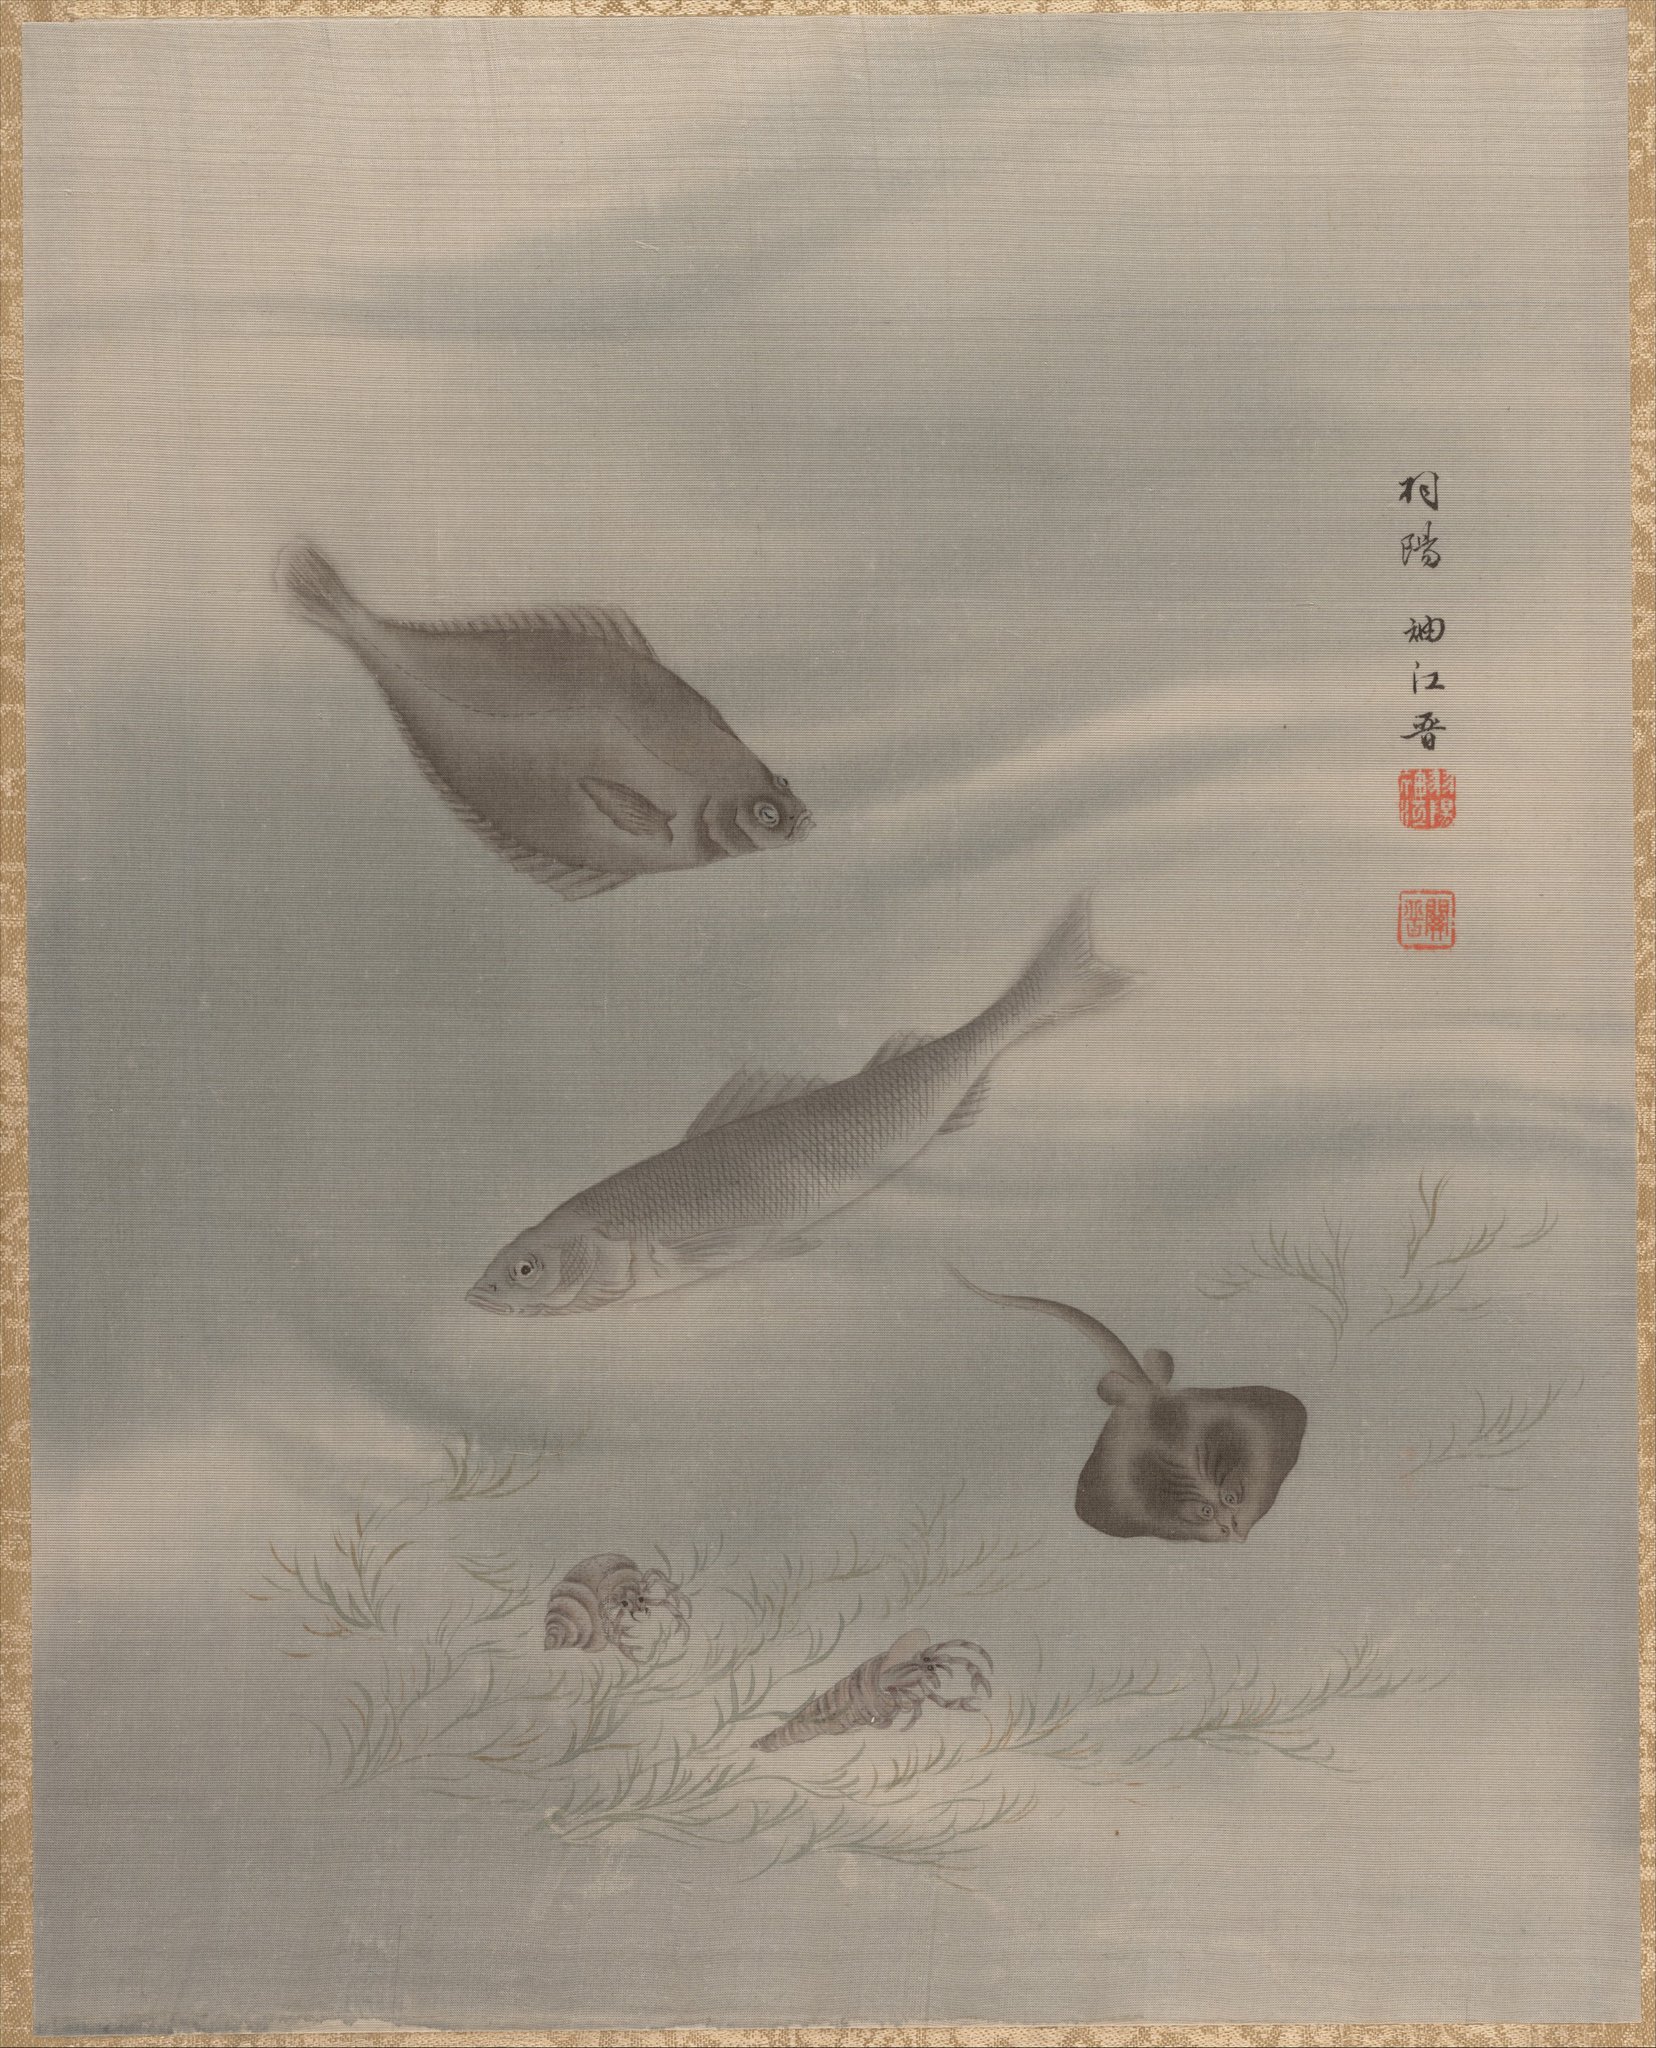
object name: album leaf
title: Fishes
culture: japanese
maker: seki shūkō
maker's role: artist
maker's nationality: japanese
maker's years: 1858-1915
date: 1890-1892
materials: silk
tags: fish